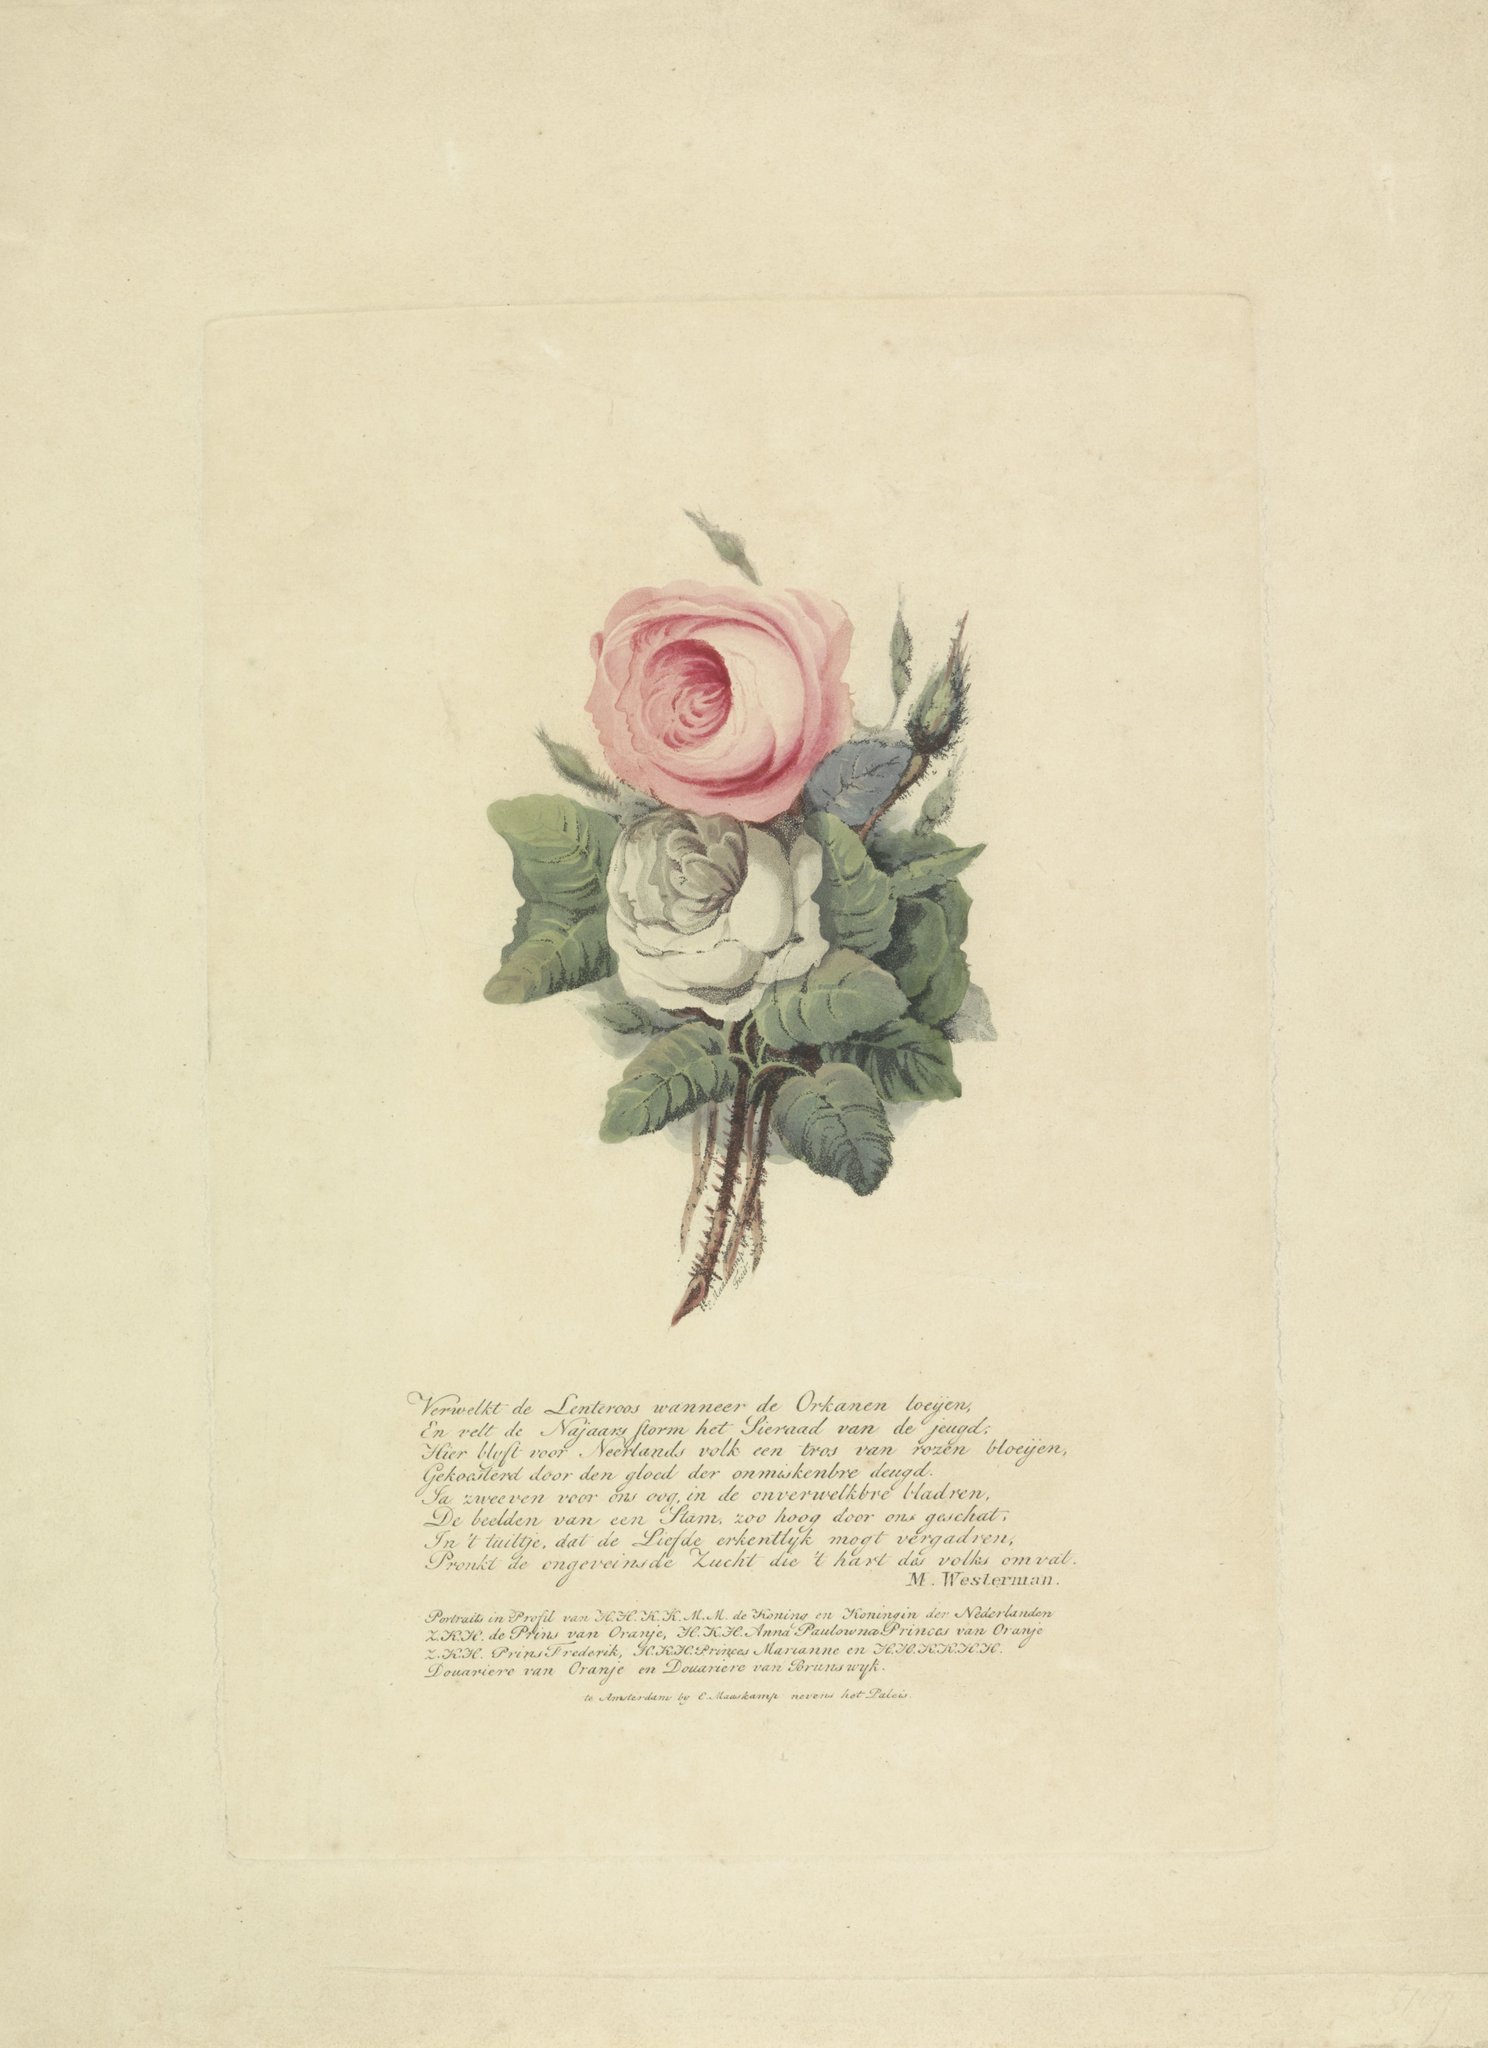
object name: print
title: Rozen met de silhouetten van de Koninklijke familie, 1816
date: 1816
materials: paper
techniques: hand coloring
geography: amsterdam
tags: anna paulowna romanowa, william i of the netherlands, william ii of the netherlands, draughtsman, wilhelmina of prussia (princess of orange), amsterdam, louise (prinses van oranje-nassau), berlin, frederik (prins der nederlanden), voorburg, marianne (prinses der nederlanden), wilhelmina frederica louisa (koningin der nederlanden), flowers: rose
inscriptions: collector's mark: Lugt 2228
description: Boeket met een roze en een witte roos waarin de silhouetten van de Koninklijke familie zijn verwerkt. Naar aanleiding van het huwelijk van de prins van Oranje en Anna Paulowna te Sint Petersburg op 21 februari 1816. Onder de bloemen een achtregelig vers en lijst van de namen van de geportretteerden. Bij de prent behoort een afzonderlijke verklaring.